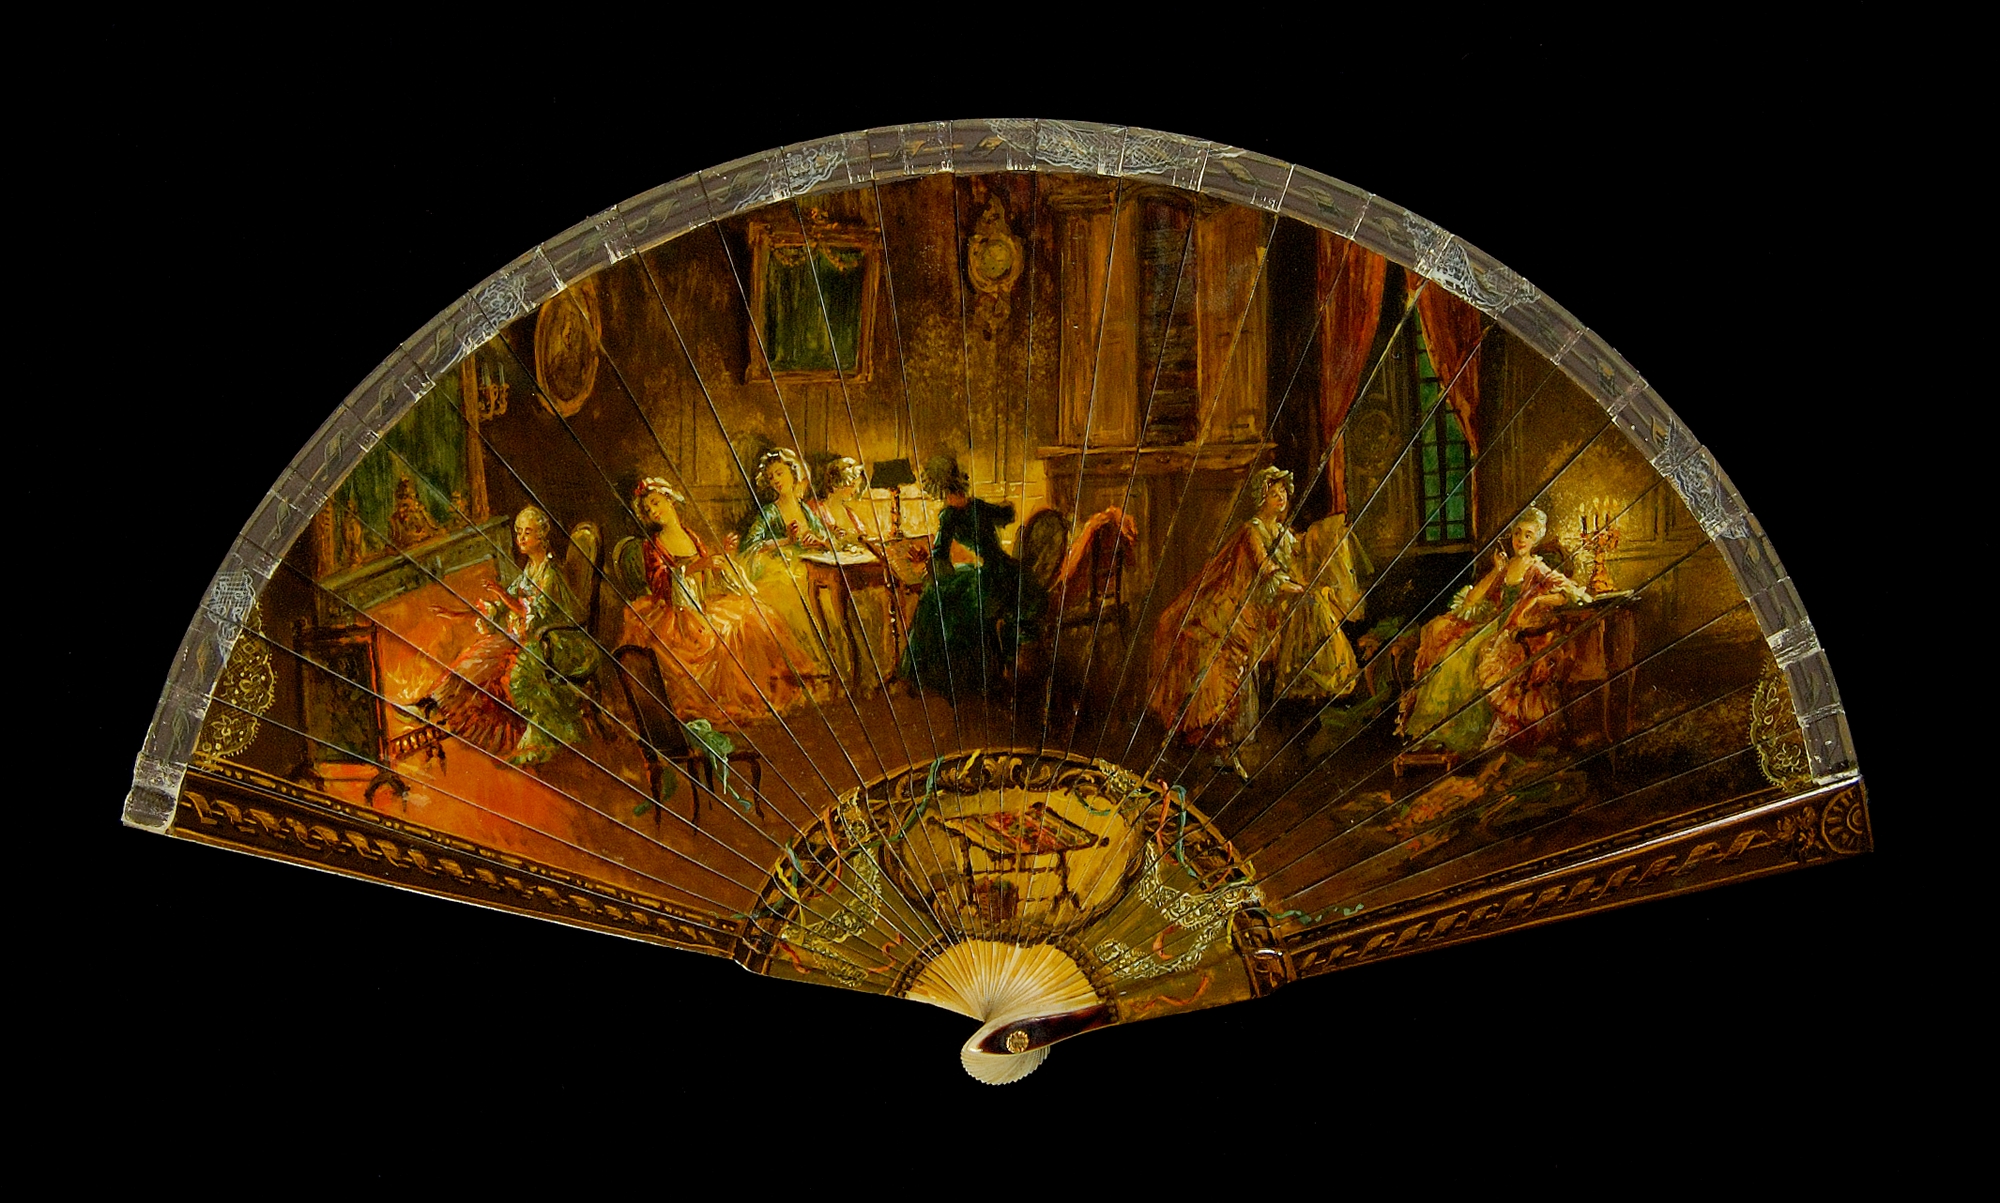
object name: brisé fan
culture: french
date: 1790-1820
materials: ivory, paper, shell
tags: interiors,women,rain